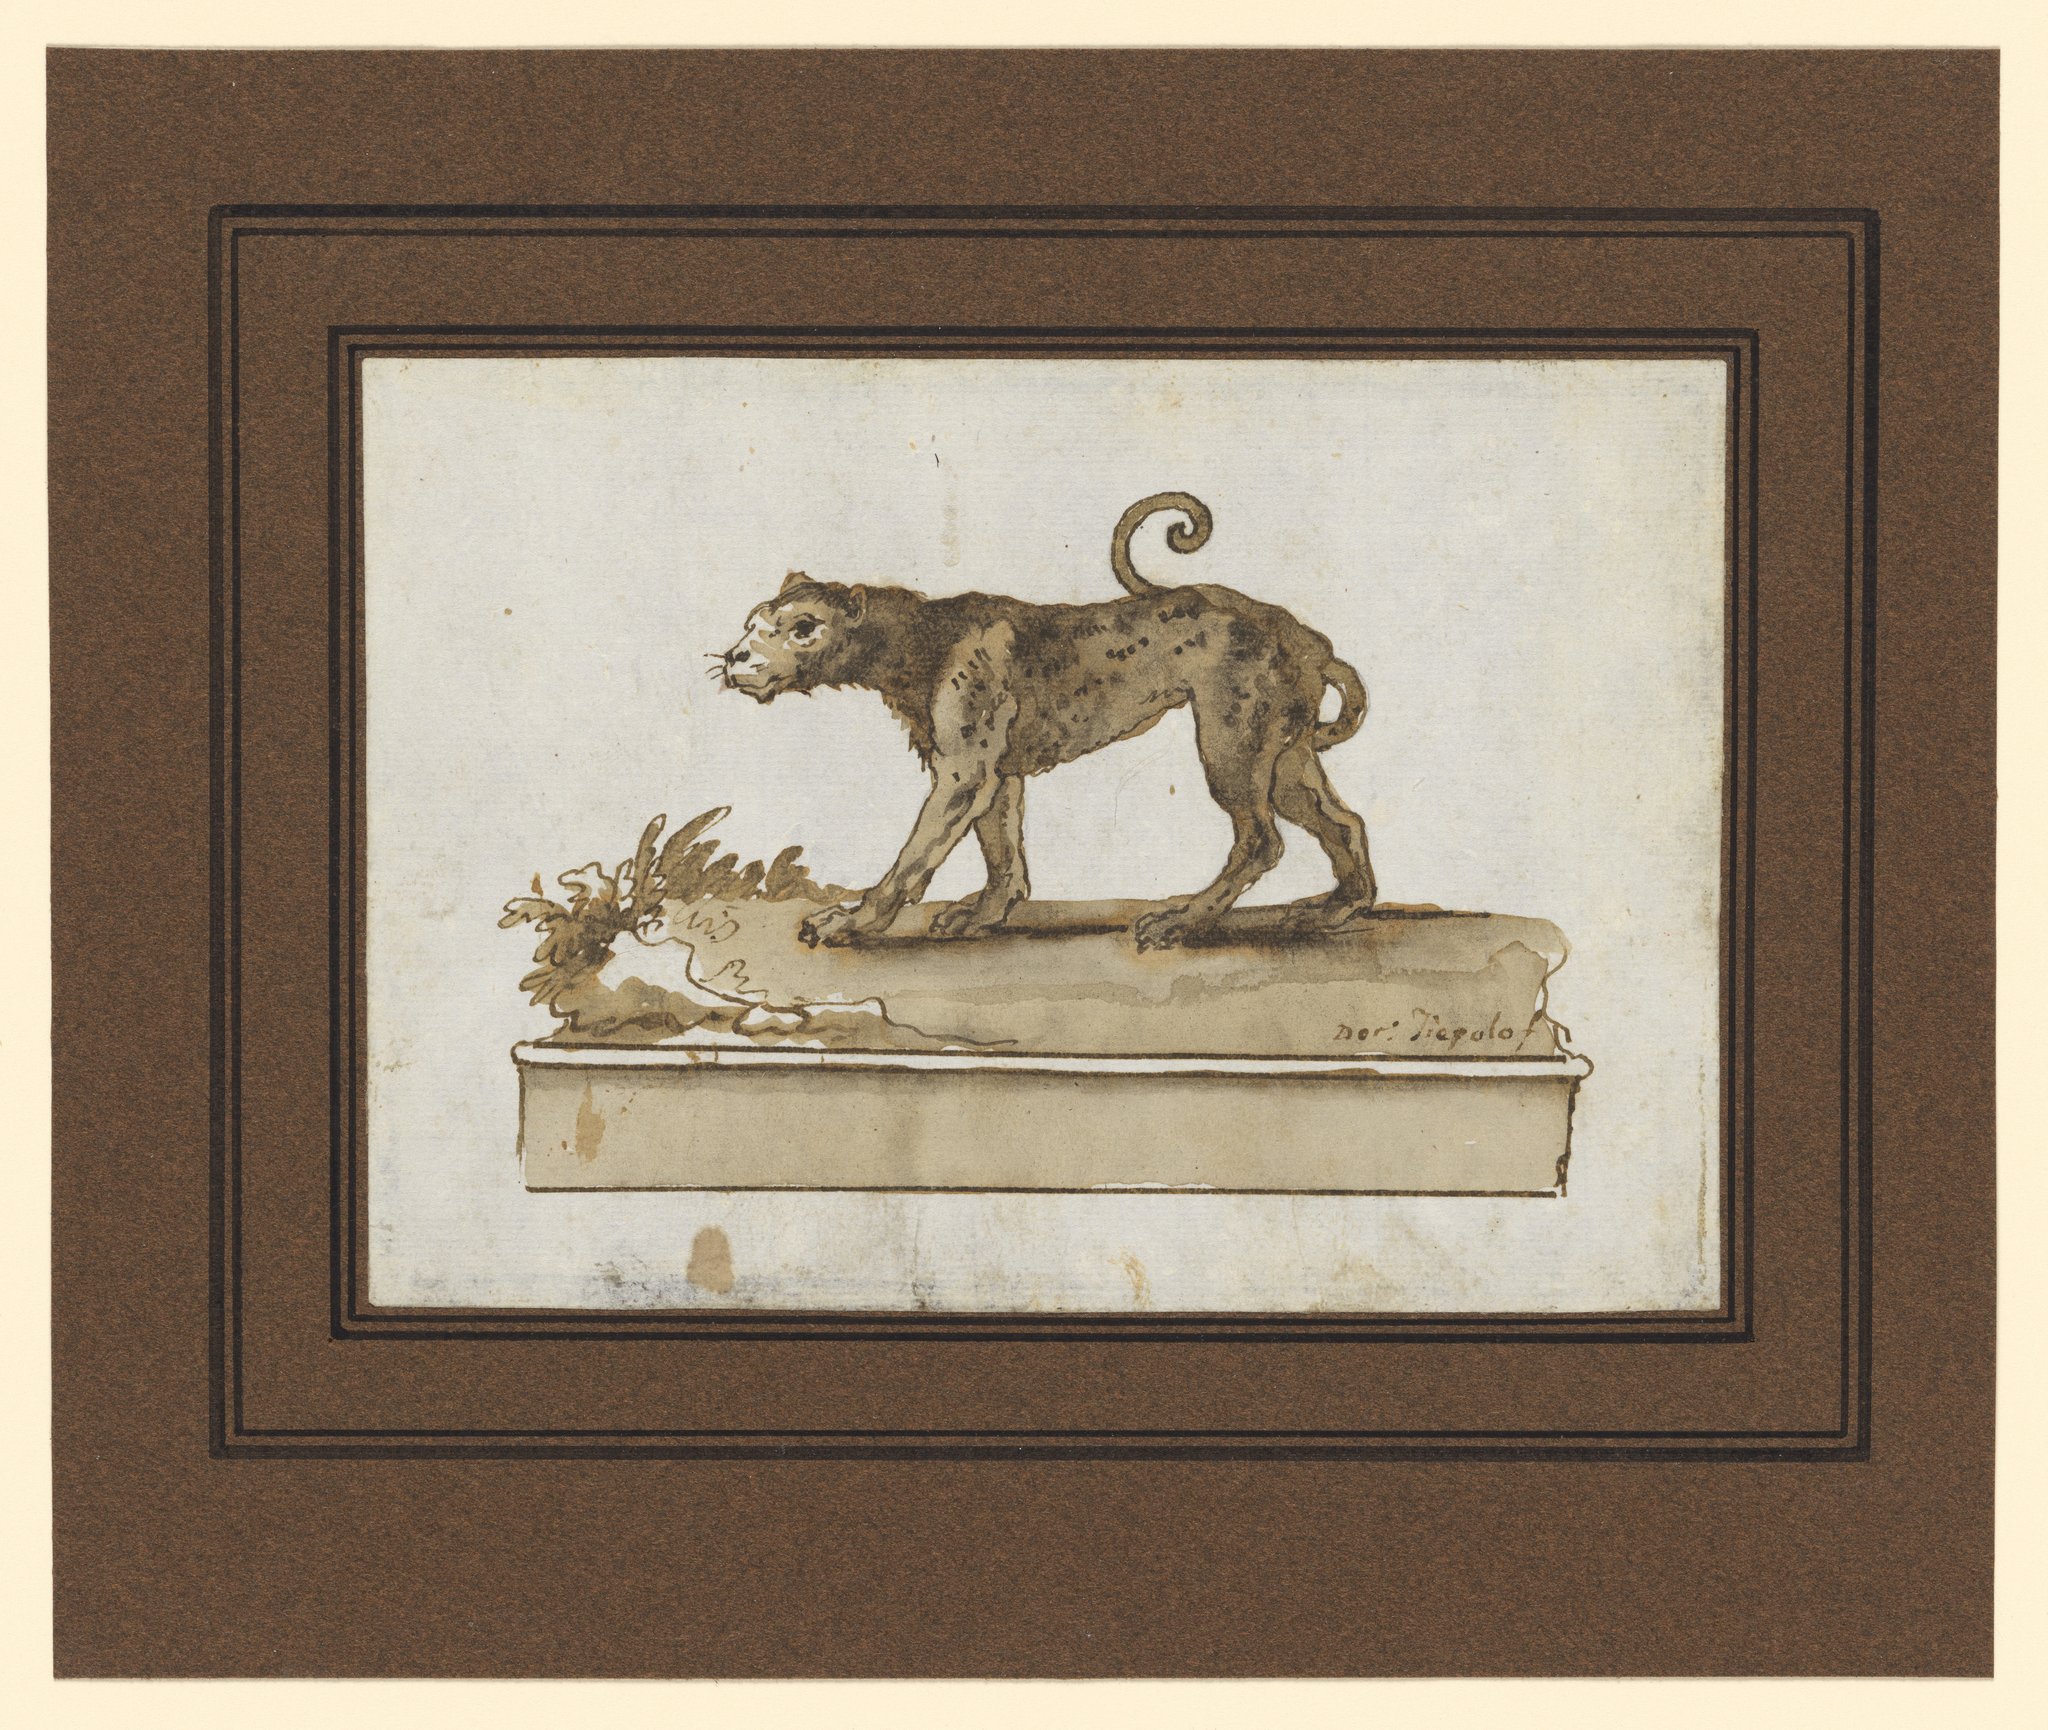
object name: drawing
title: A Leopard, Moving to the Left (on a Base)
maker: giovanni domenico tiepolo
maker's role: artist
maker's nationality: italian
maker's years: 1727-1804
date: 1734-1833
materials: chalk, ink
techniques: pen, wash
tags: leopards